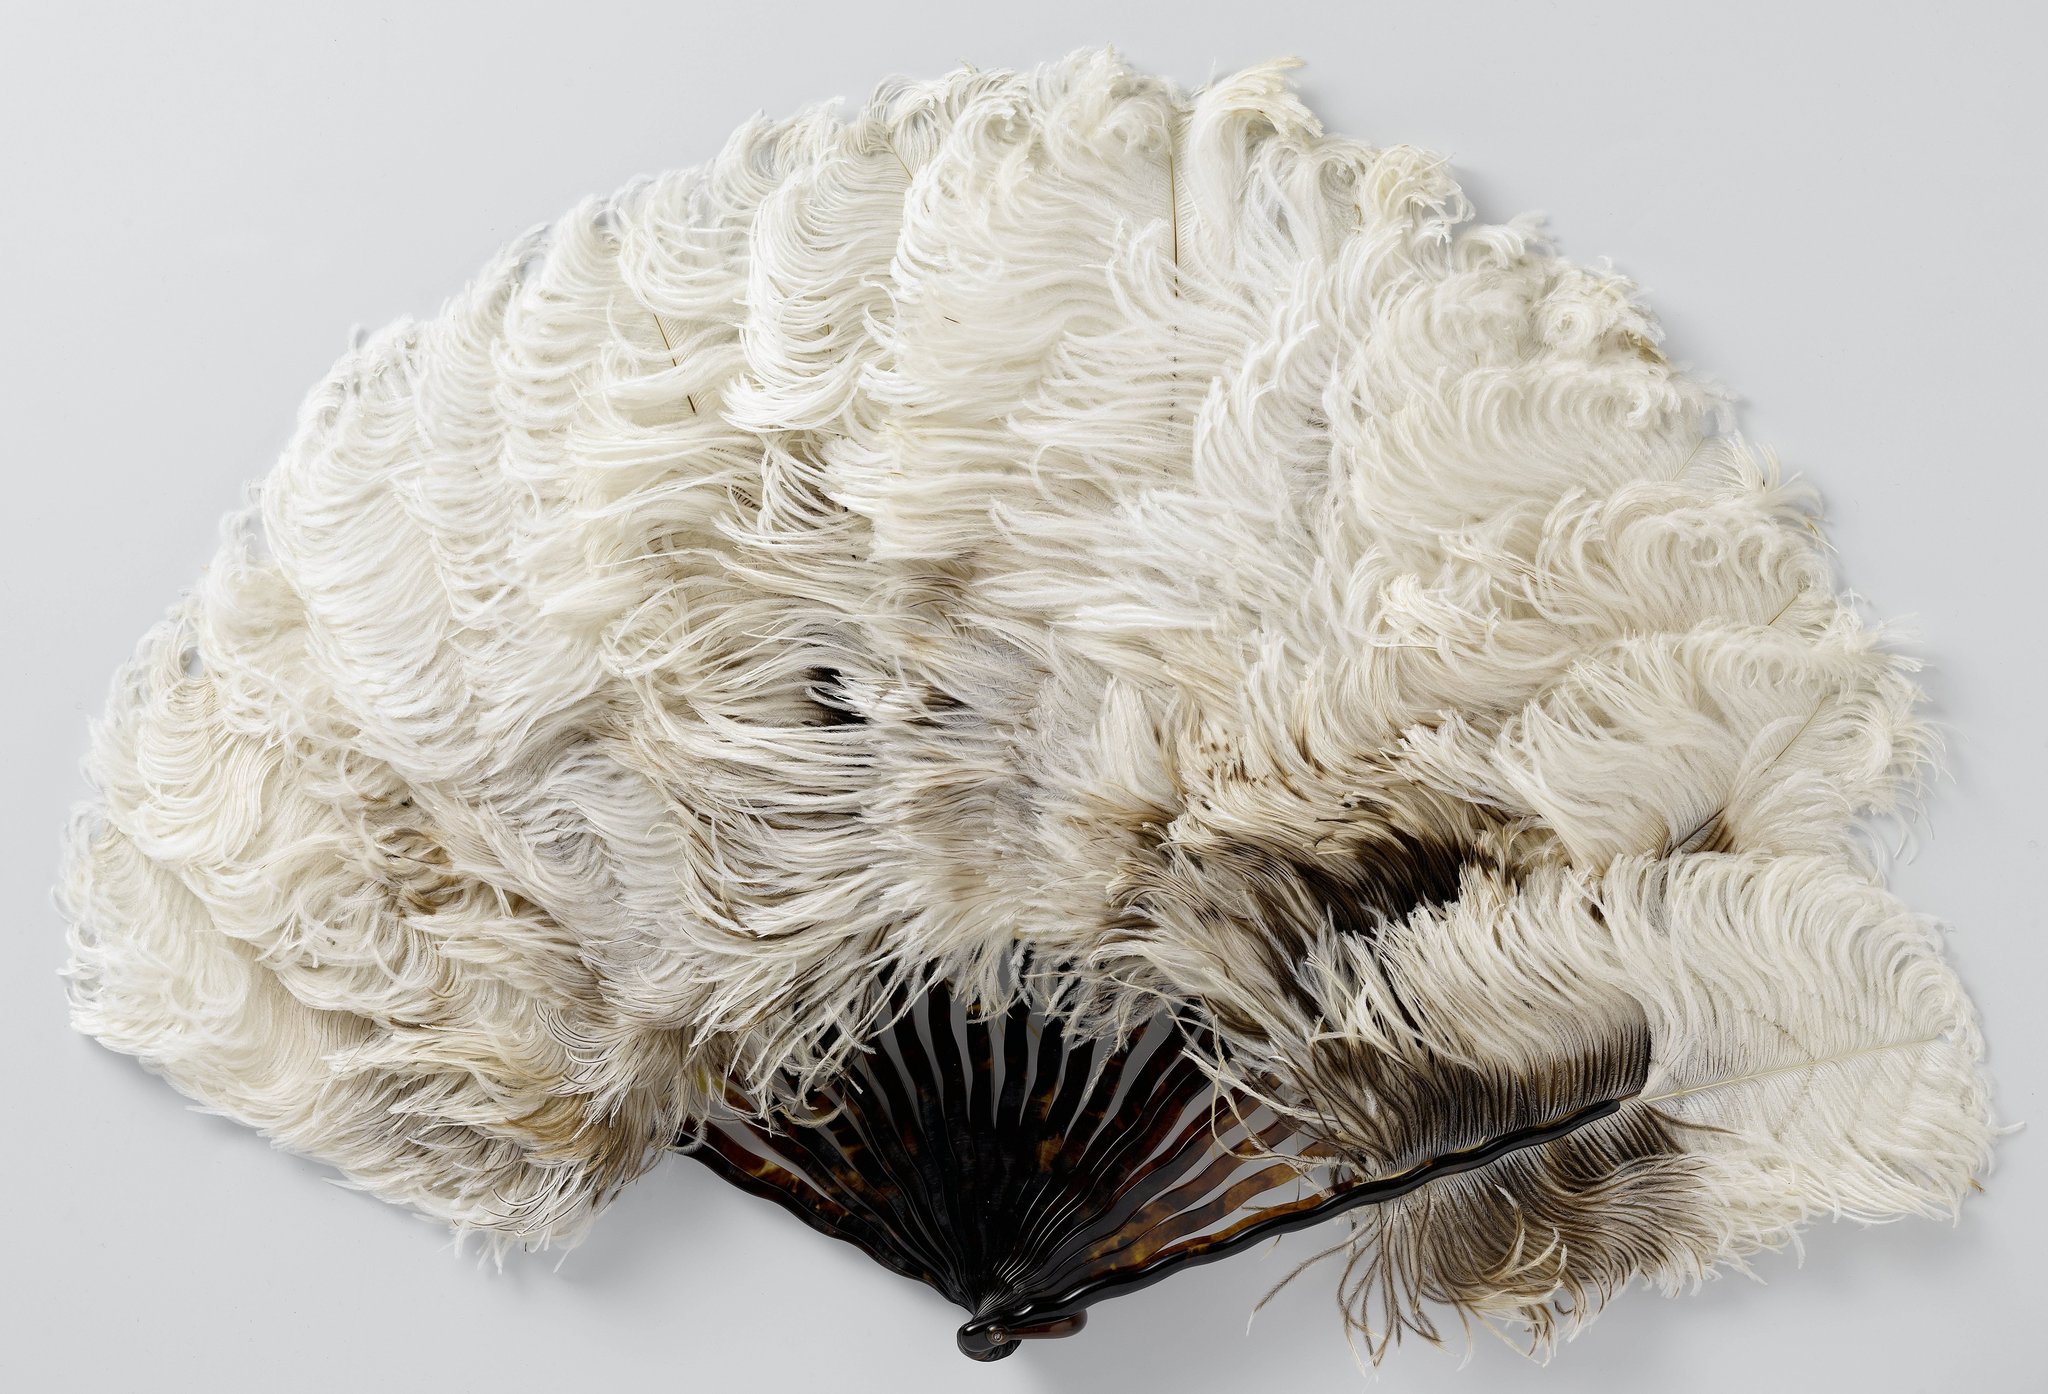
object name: vouwwaaier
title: Vouwwaaier van witbruine struisveren op een montuur van smalle, gekronkelde benen van kunststof met schildpadmotief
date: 1900-1925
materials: plastic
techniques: pressing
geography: amsterdam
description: Vouwwaaier van witbruine struisveren op een montuur van smalle, gekronkelde benen van kunststof met schildpadmotief. De 24 benen zijn niet aaneengesloten en onversierd. Aan het montuur een waaiering van schildpad.